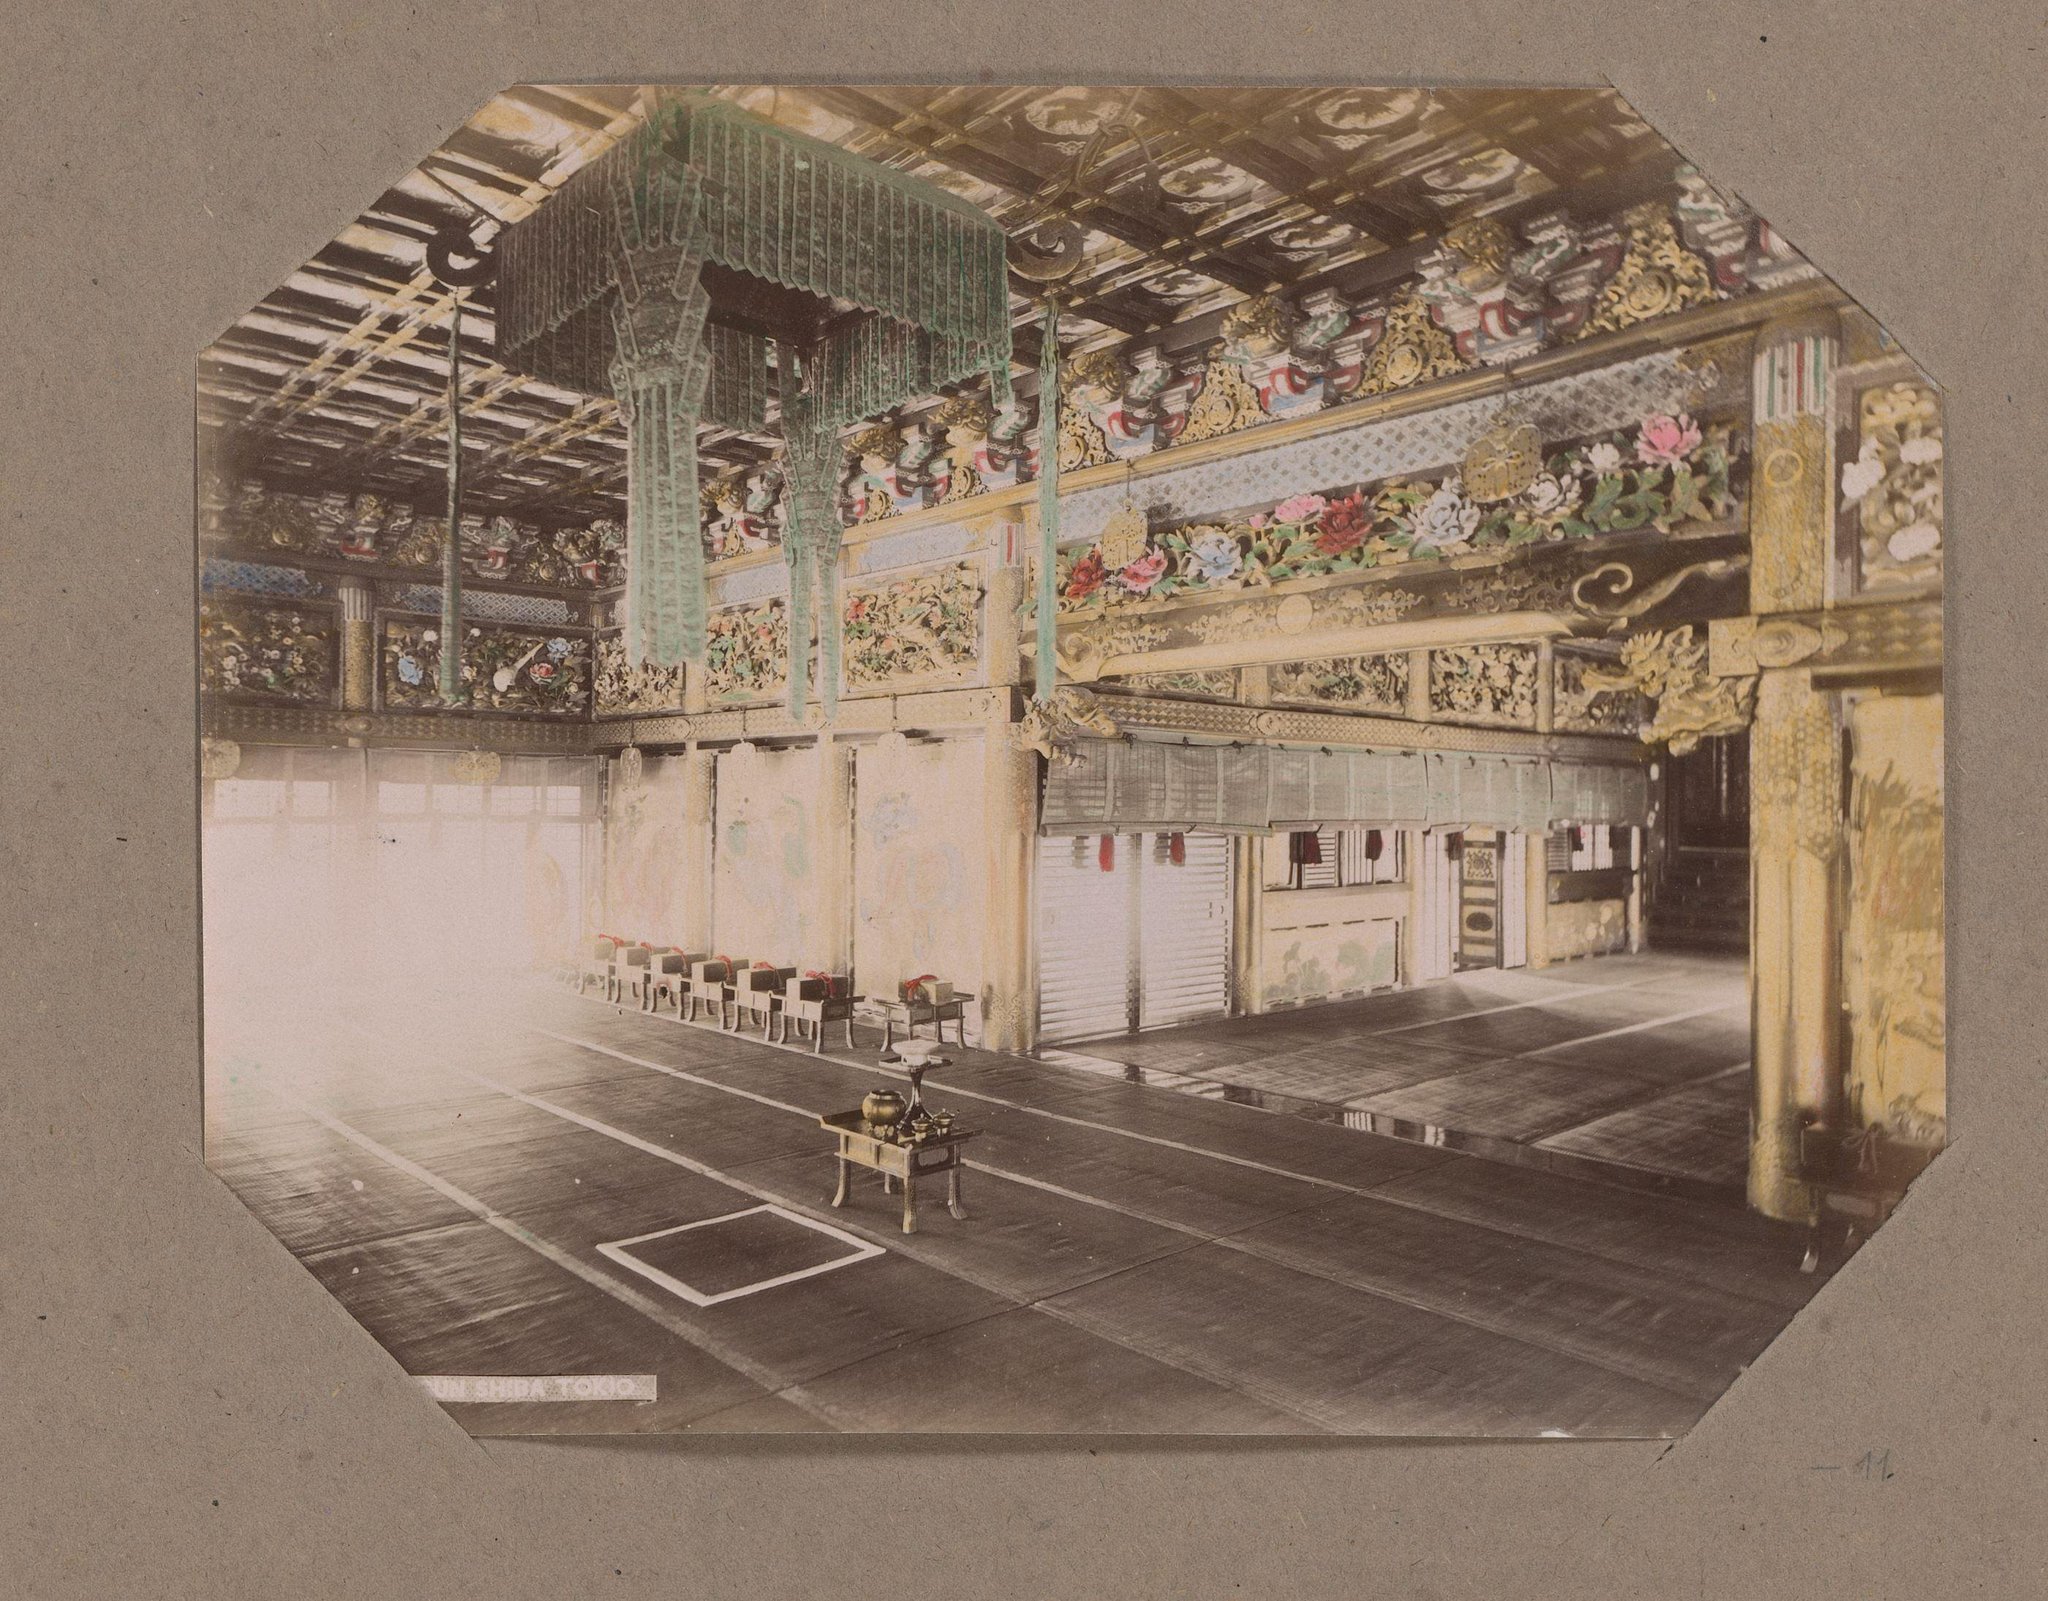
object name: photograph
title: Interieur van één van de gebouwen van het tempelcomplex Zojo-ji in Shiba, Tokyo, Japan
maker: Anonymous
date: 1890-1903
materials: paper, photographic support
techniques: albumen print, hand coloring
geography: tokyo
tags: temple, shrine ~ hinduism, buddhism, jainism, interior of the house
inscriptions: inscription: ‘199 Oth Shogun Shiba Tokio’